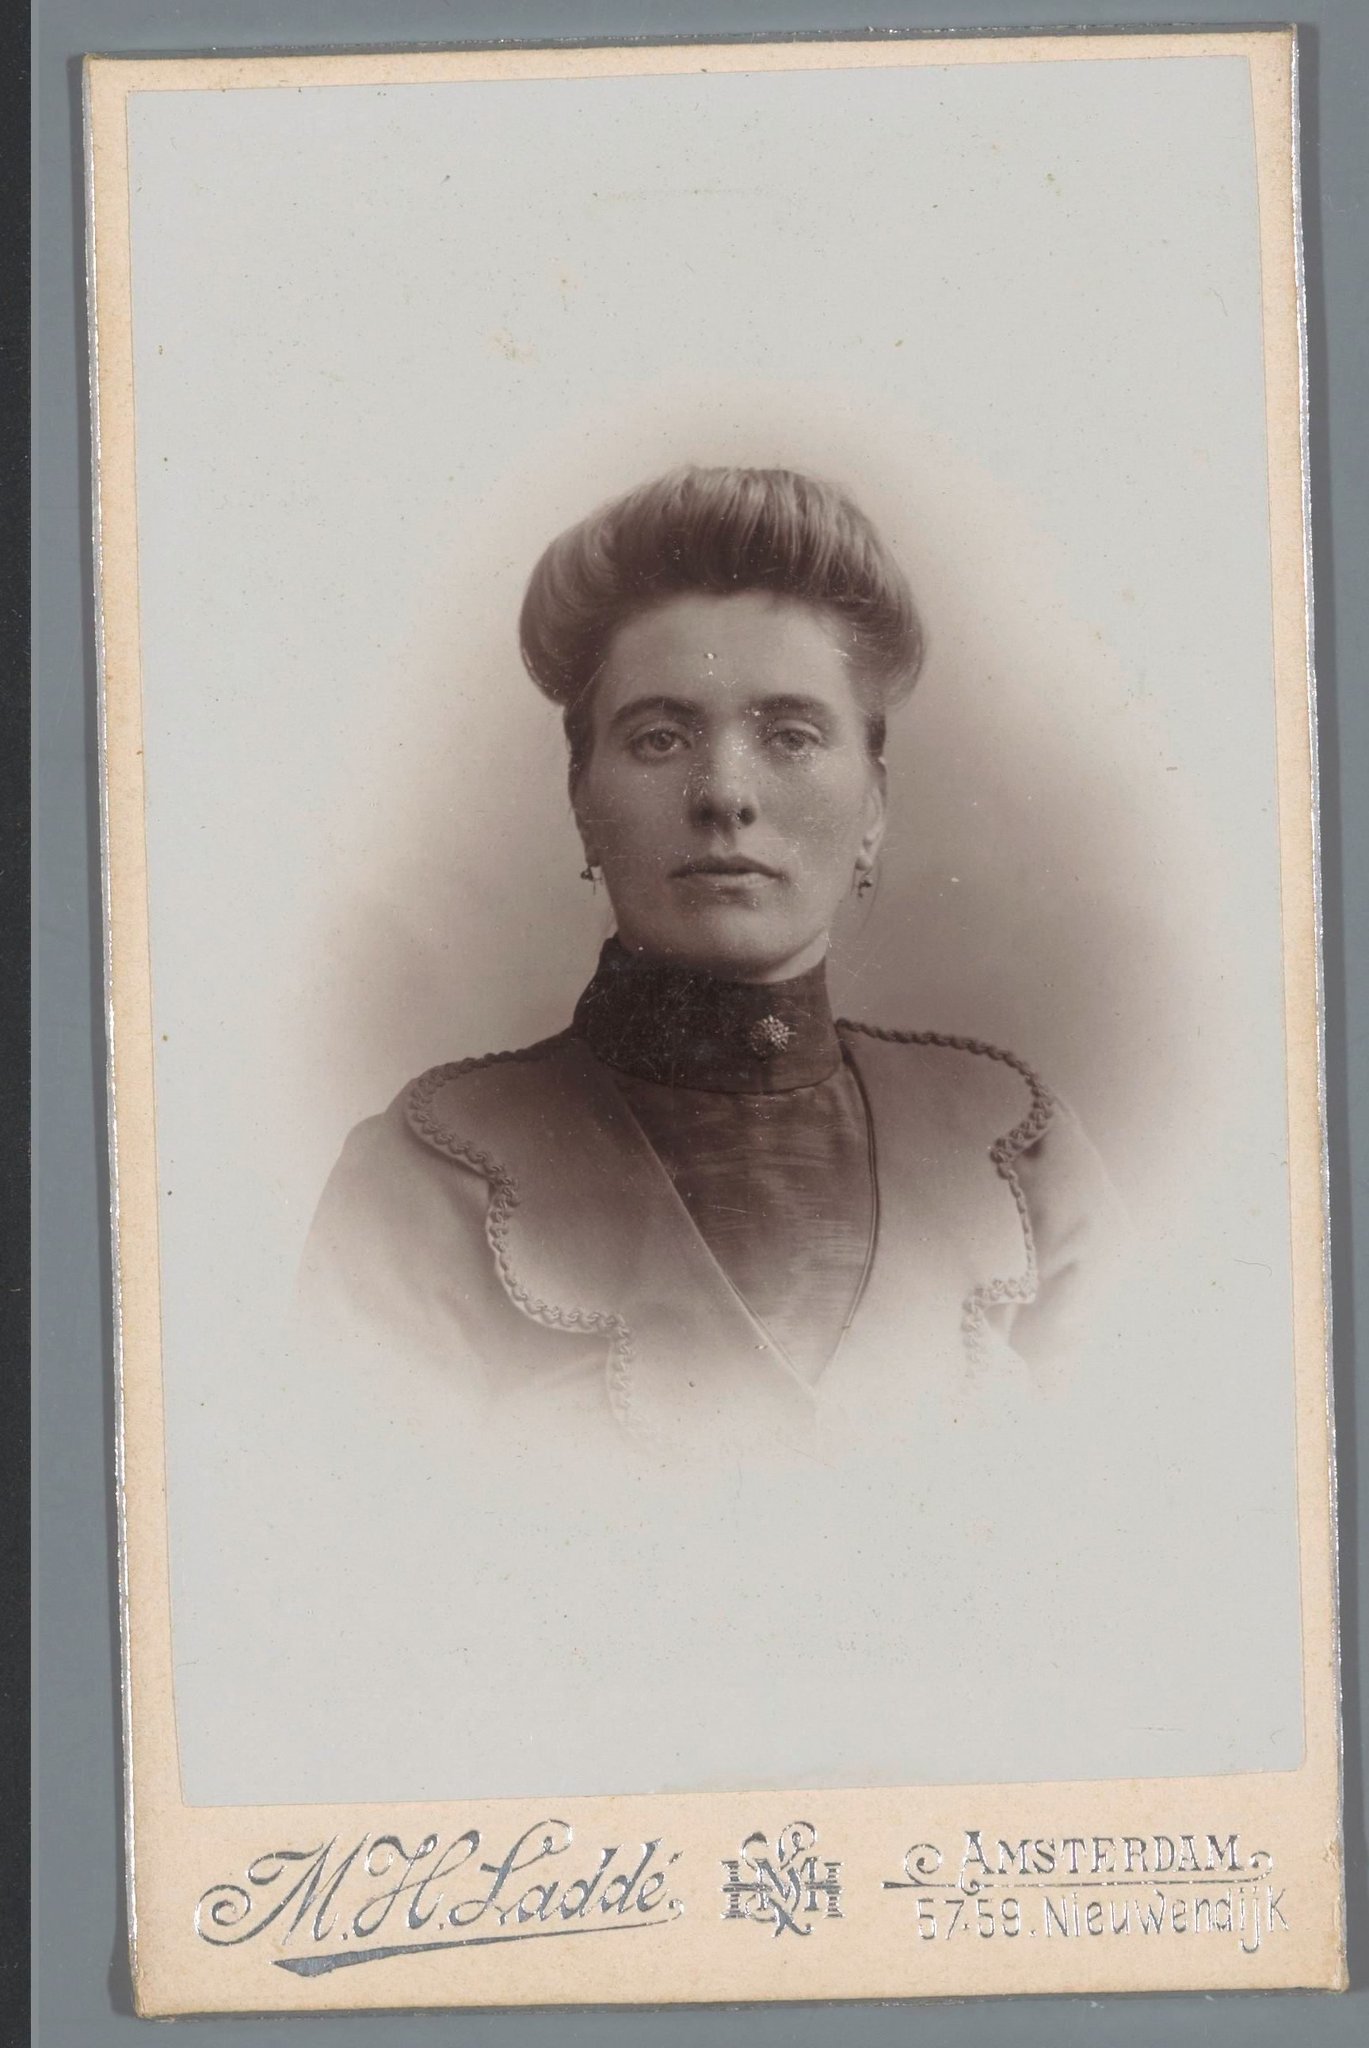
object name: photograph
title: Portret van Jaantje Kronenburg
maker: machiel hendricus laddé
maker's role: fotograaf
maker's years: 1866-1932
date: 1892-1906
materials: paper, cardboard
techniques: collodion silver print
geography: amsterdam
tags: adult woman, historical persons, amsterdam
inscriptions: inscription: ‘Het Cliche wordt voor verdere bestellingen bewaard/ L GEVAERT & Co. VIEUX DIEU.’, inscription: ‘Jaantje Kronenburg/ x/ Engel Wolders’, address: ‘BOVEN DE FIRMA/ MERKELBACH & Co./ AMSTERDAM/ 57-59/ NIEUWENDIJK’